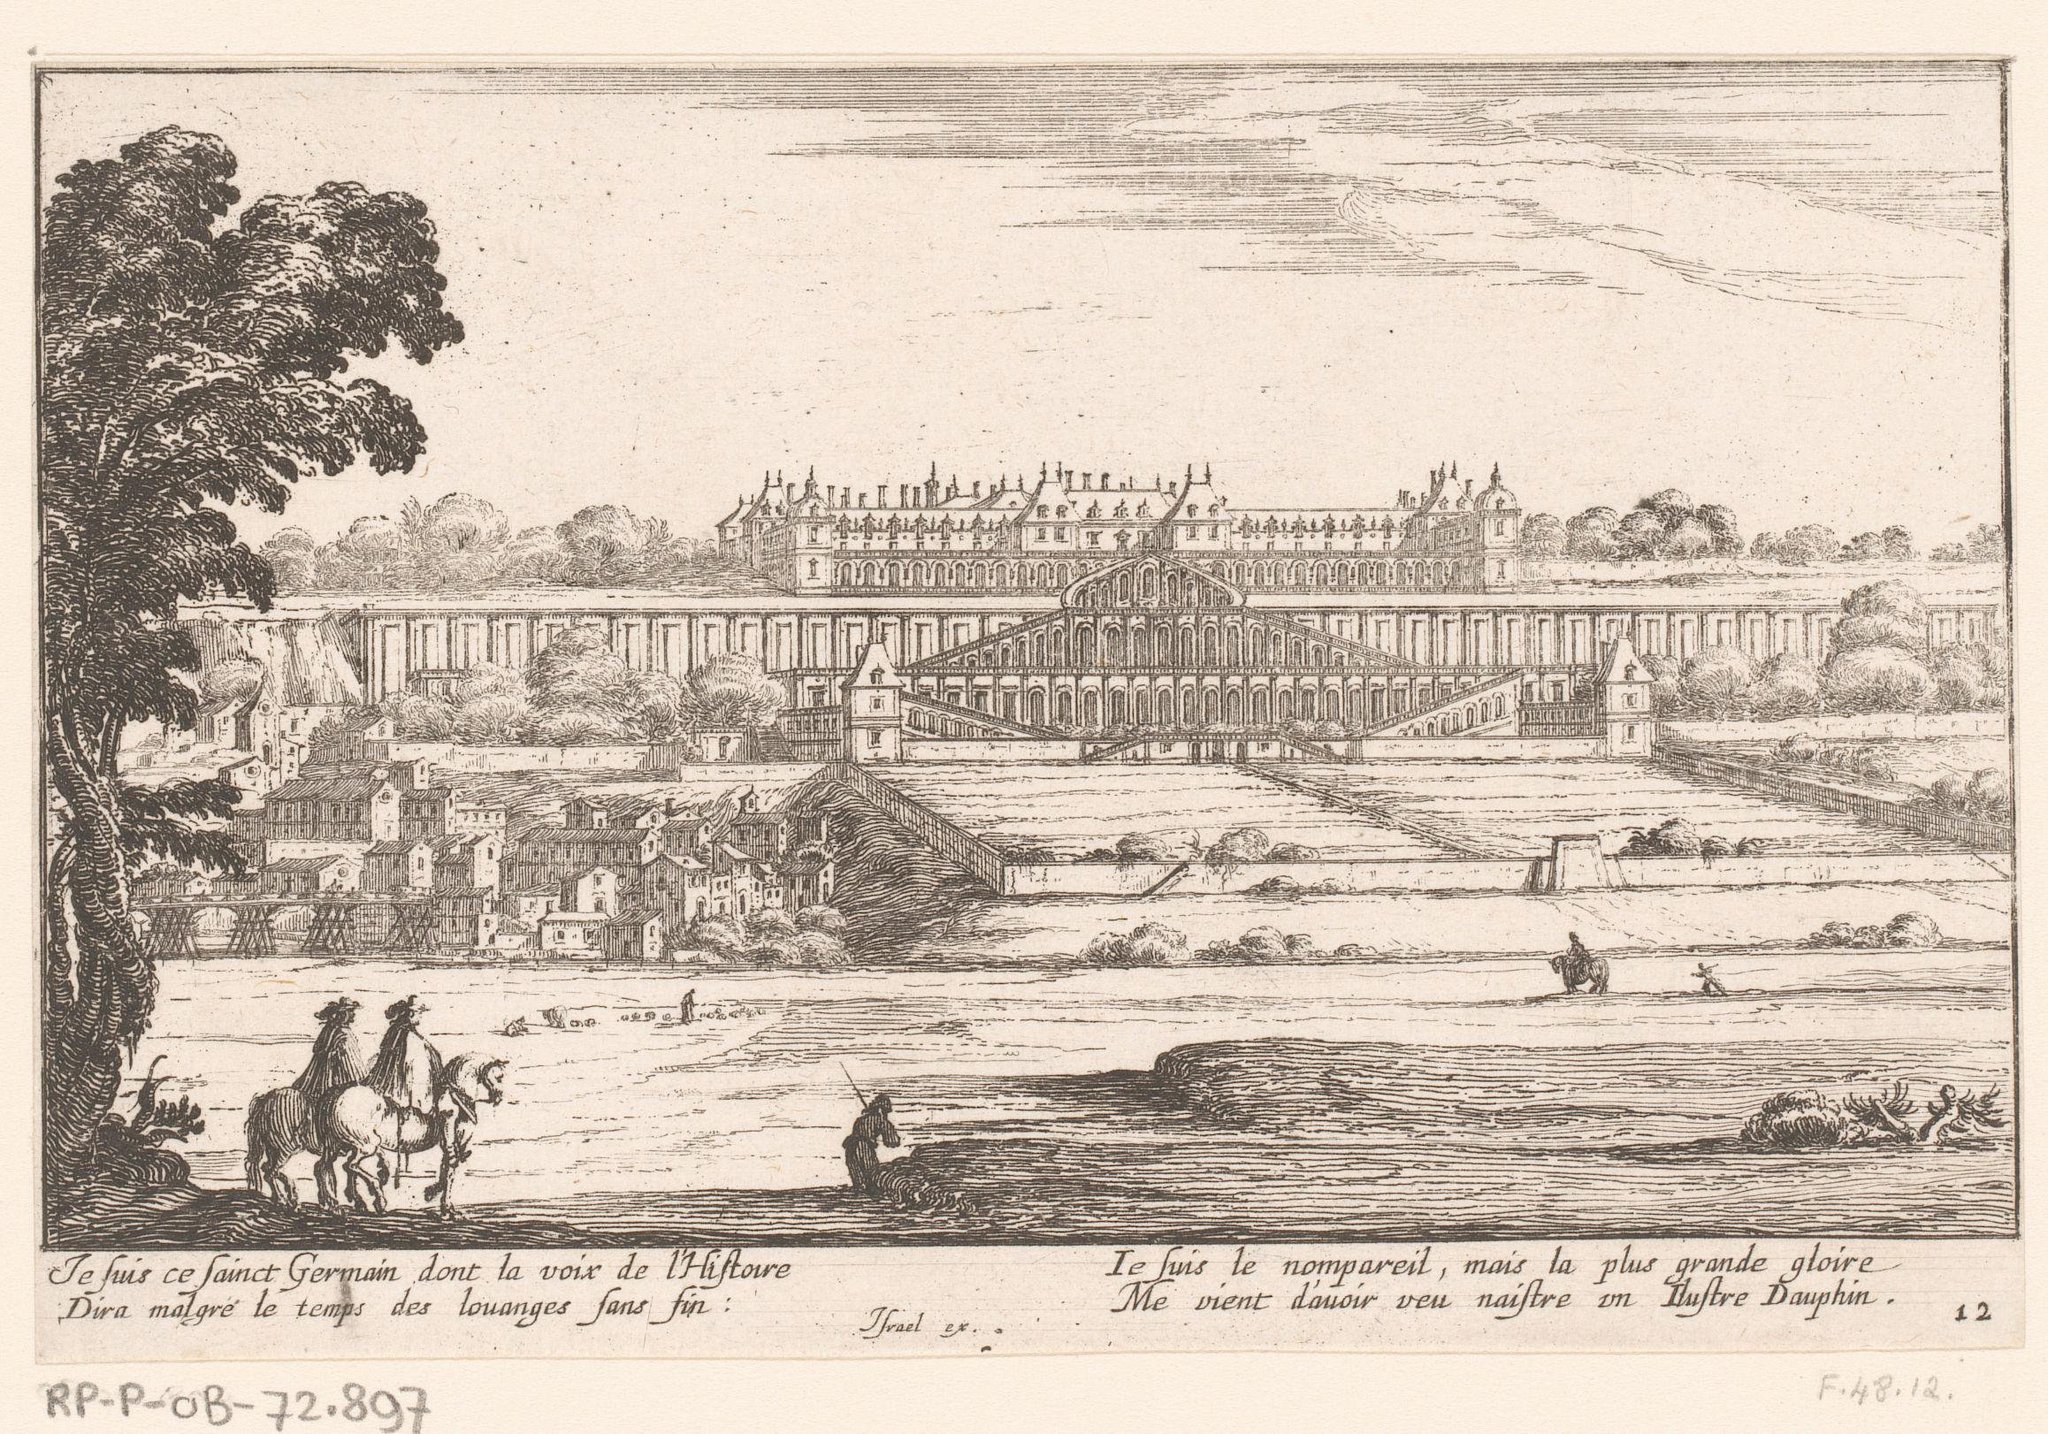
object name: print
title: Les lieux les plus remarquables de Paris et des environs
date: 1655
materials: paper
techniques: engraving, etching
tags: city-view, and landscape with man-made constructions (+ city(-scape) with figures, staffage)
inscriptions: collector's mark: Lugt 240